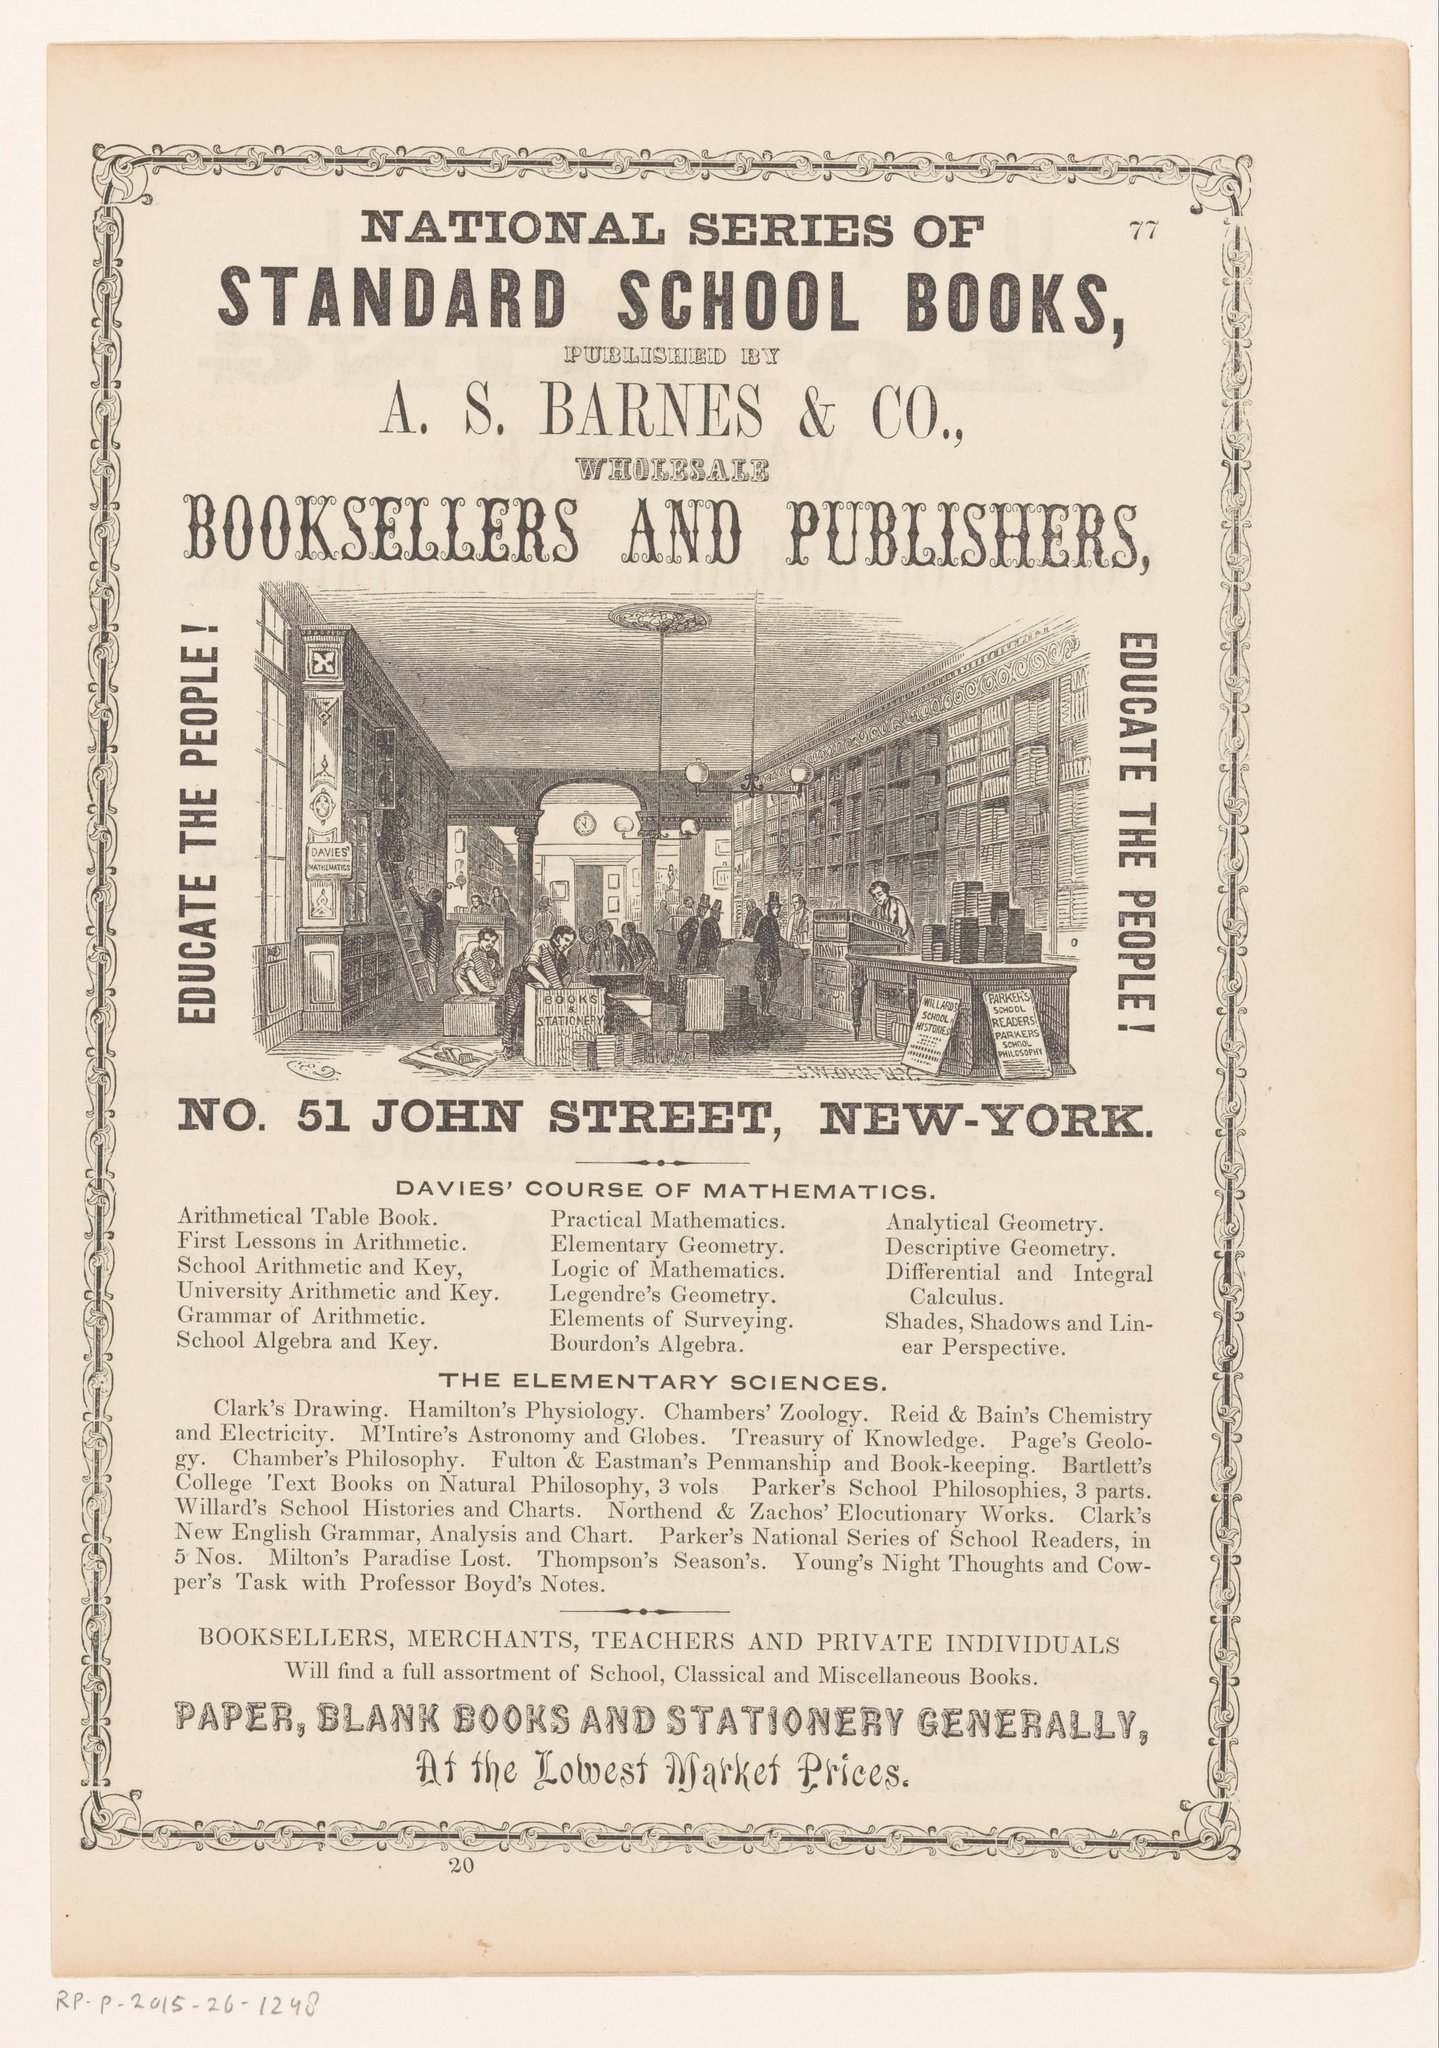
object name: print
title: Advertentie voor schoolboeken uitgegeven door A.S. Barnes & Co. te New York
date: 1865-1887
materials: paper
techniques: letterpress printing, engraving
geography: new york city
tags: book-shop, bookseller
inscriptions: collector's mark: Lugt 4779, collector's mark: Lugt 2228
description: Interieur van A.S. Barnes & Co., 51 John Street te New York, met op de voorgrond mannen die dozen in- of uitpakken en rechts een toonbank. Rechtsboven genummerd: 77.